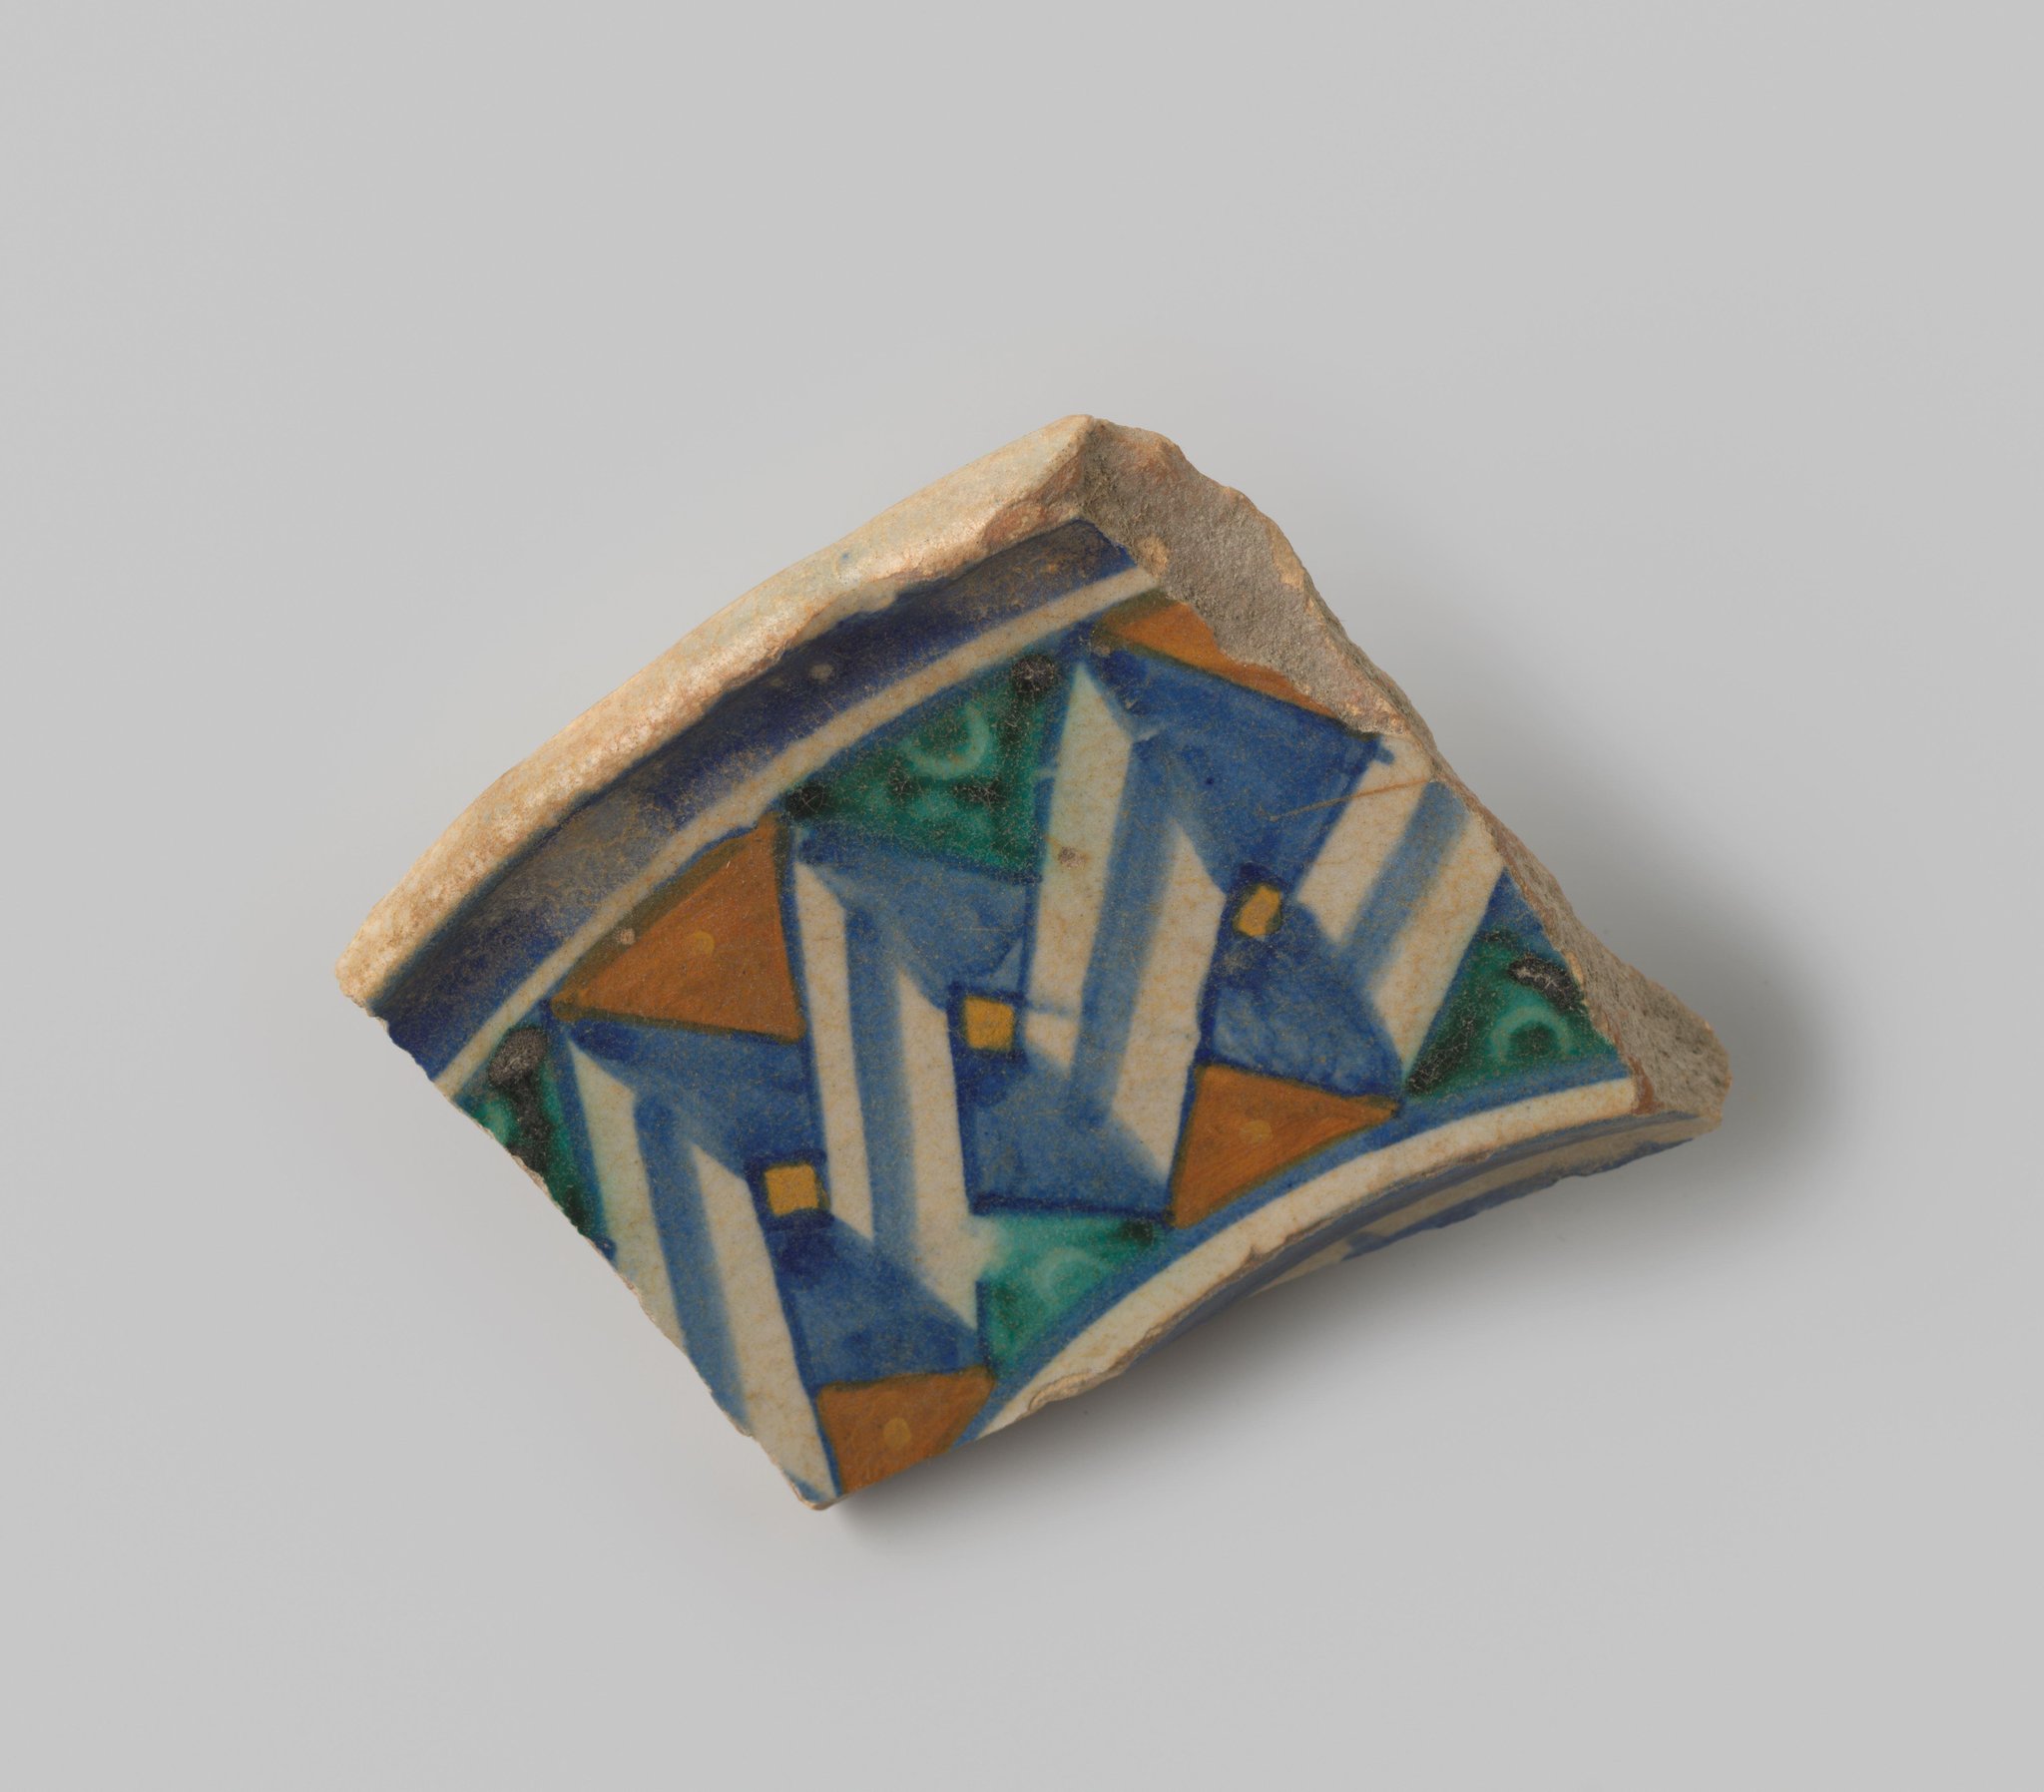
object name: sherd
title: Fragment van grijsbakkend aardewerk, voorzien van een geometrisch patroon in wit, blauw, groen en oranje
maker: Anonymous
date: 1200-1899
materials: earthenware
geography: italy